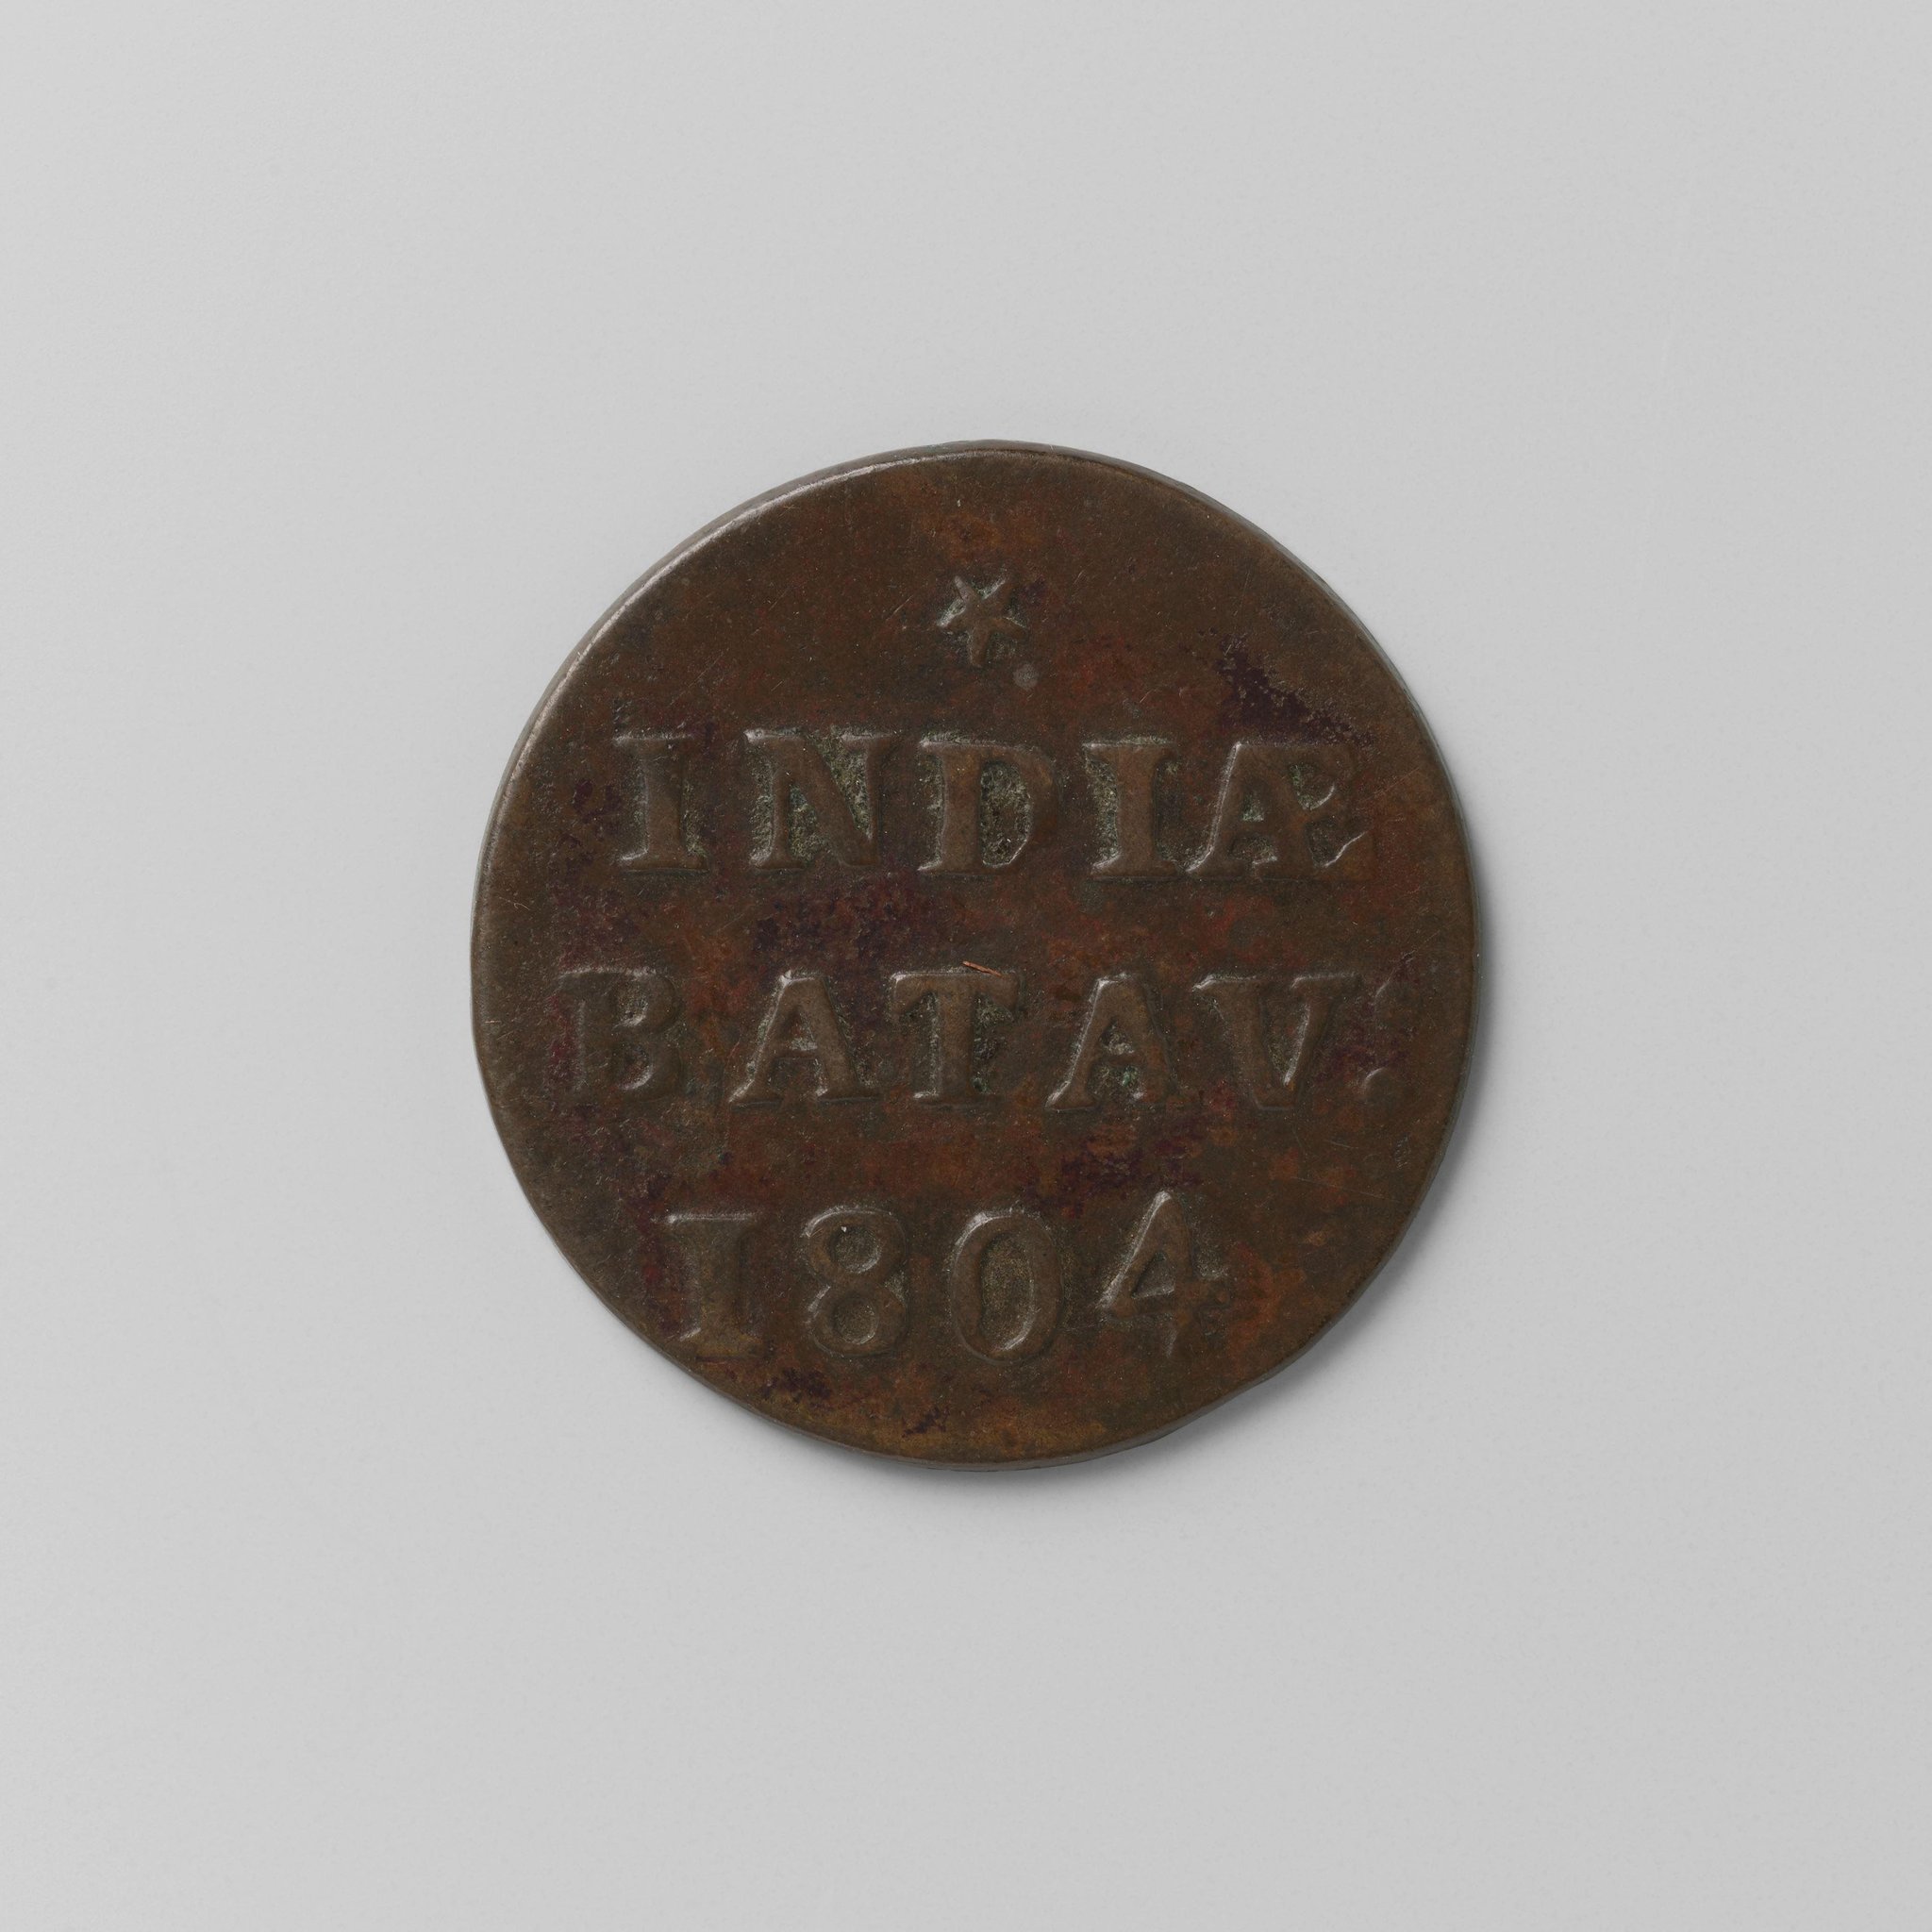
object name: coin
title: Duit voor Nederlands Indië uit Holland,1804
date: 1804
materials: copper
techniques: striking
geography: hoorn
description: Koperen munt. Voorzijde: tweeregelig opschrift, waarboven muntteken ster en waaronder jaartal. Keerzijde: tussen waarde-aanduiding 5 1/16 G gekroond generaliteitswapenschild. Gladde rand.